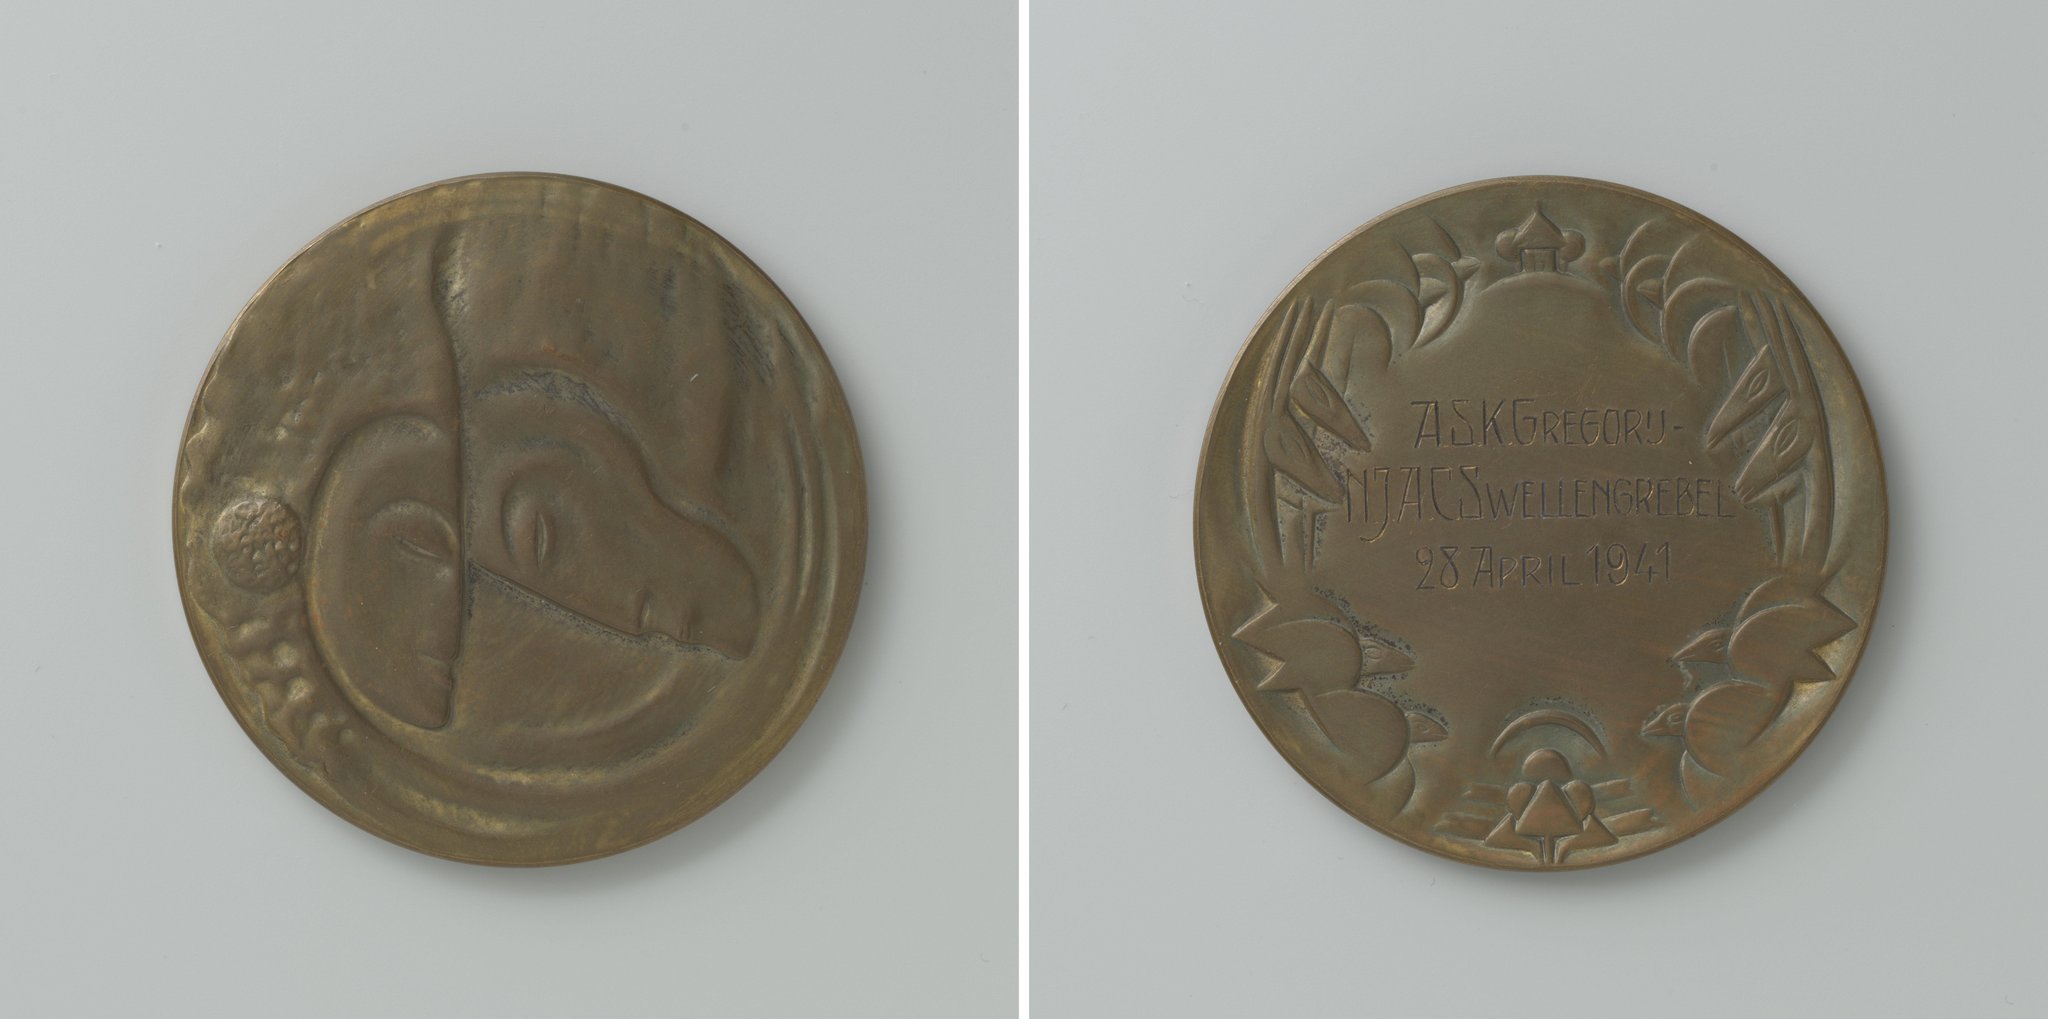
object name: marriage medal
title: Wedding medal of Anne Sofie Knagenhjelm Gregory & Nicolaas Jan Agatho Christiaan Swellengrebel.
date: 1941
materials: bronze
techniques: striking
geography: utrecht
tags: standdaarbuiten, nicolaas jan agatho christiaan swellengrebel, anne sofie knagenhjelm gregory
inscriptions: inscription: ‘A . S . K . GREGORIJ - / N . J . A . C . SWELLENGREBEL / 28 APRIL 1941’, stamp: ‘mercuriusstaf’